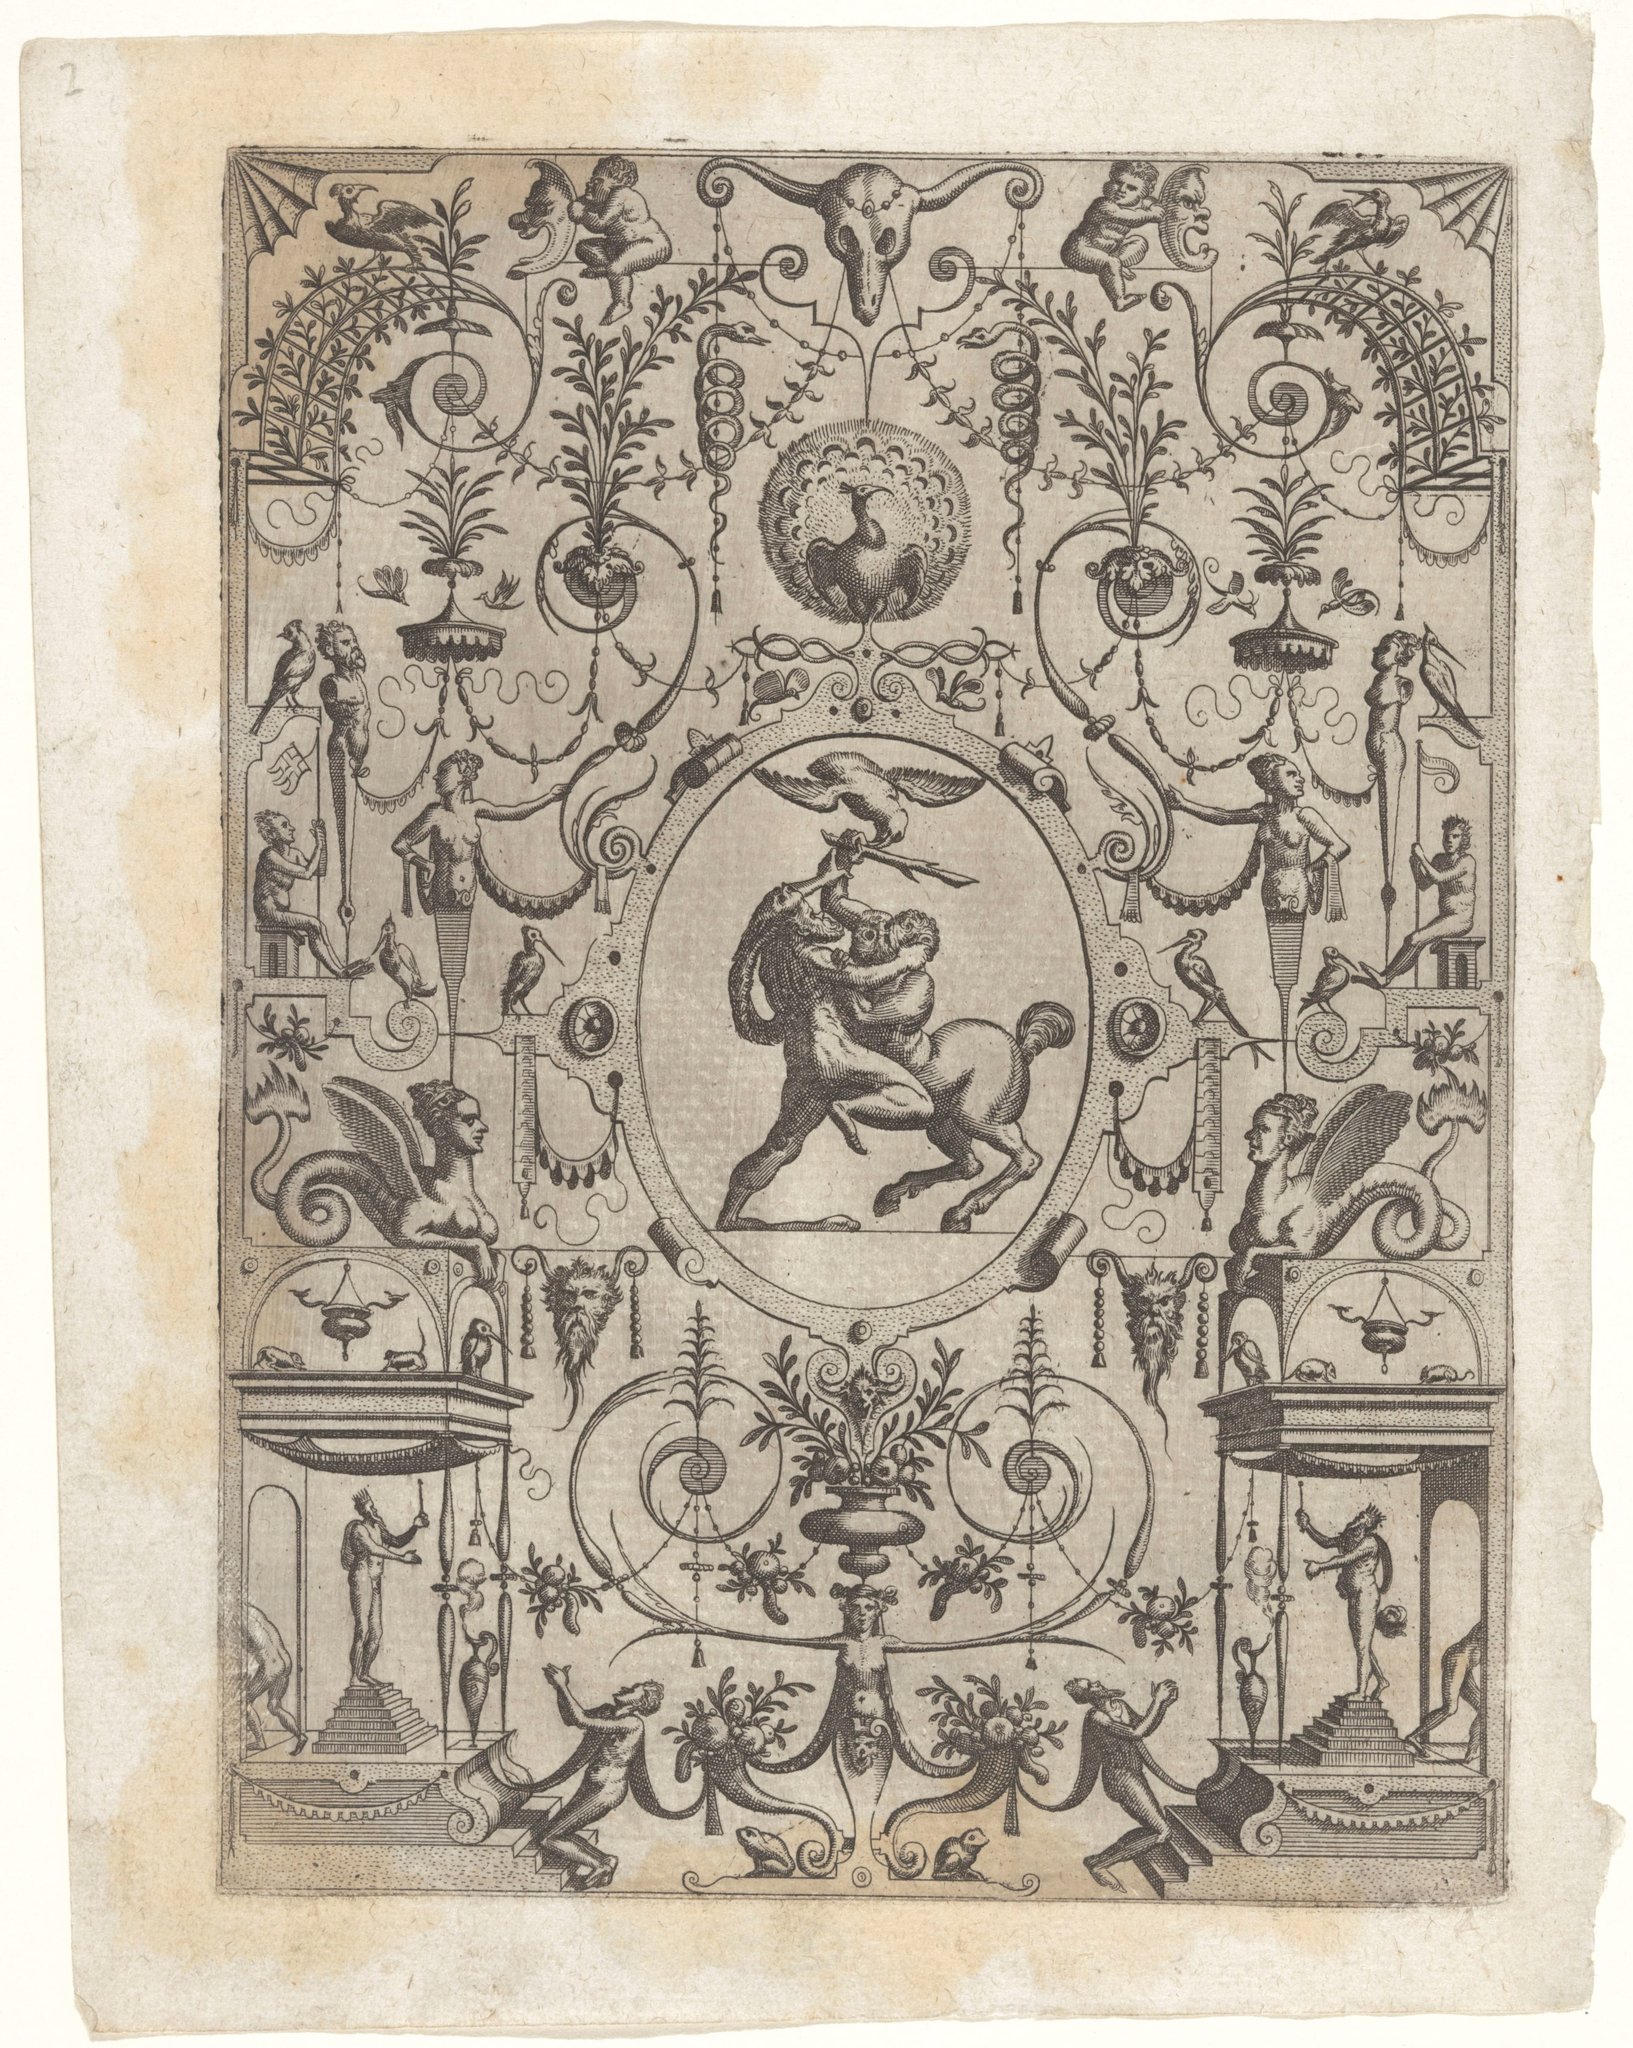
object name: print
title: Een blad met grotesken (Deutecum?)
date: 1565-1571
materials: paper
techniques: etching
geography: netherlands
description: Linksonder en rechtsonder ligt een man op zijn knieën voor een tempeltje, waarin een offerande rookt bij een godenbeeld. Op de cartouche staat een pauw. Uit serie van titelblad + 16 bladen met cartouches of architectuurfantasieën met een voorstelling in een omlijsting van grotesken met fabelwezens, dieren, guirlandes, trofeeën en mascarons.